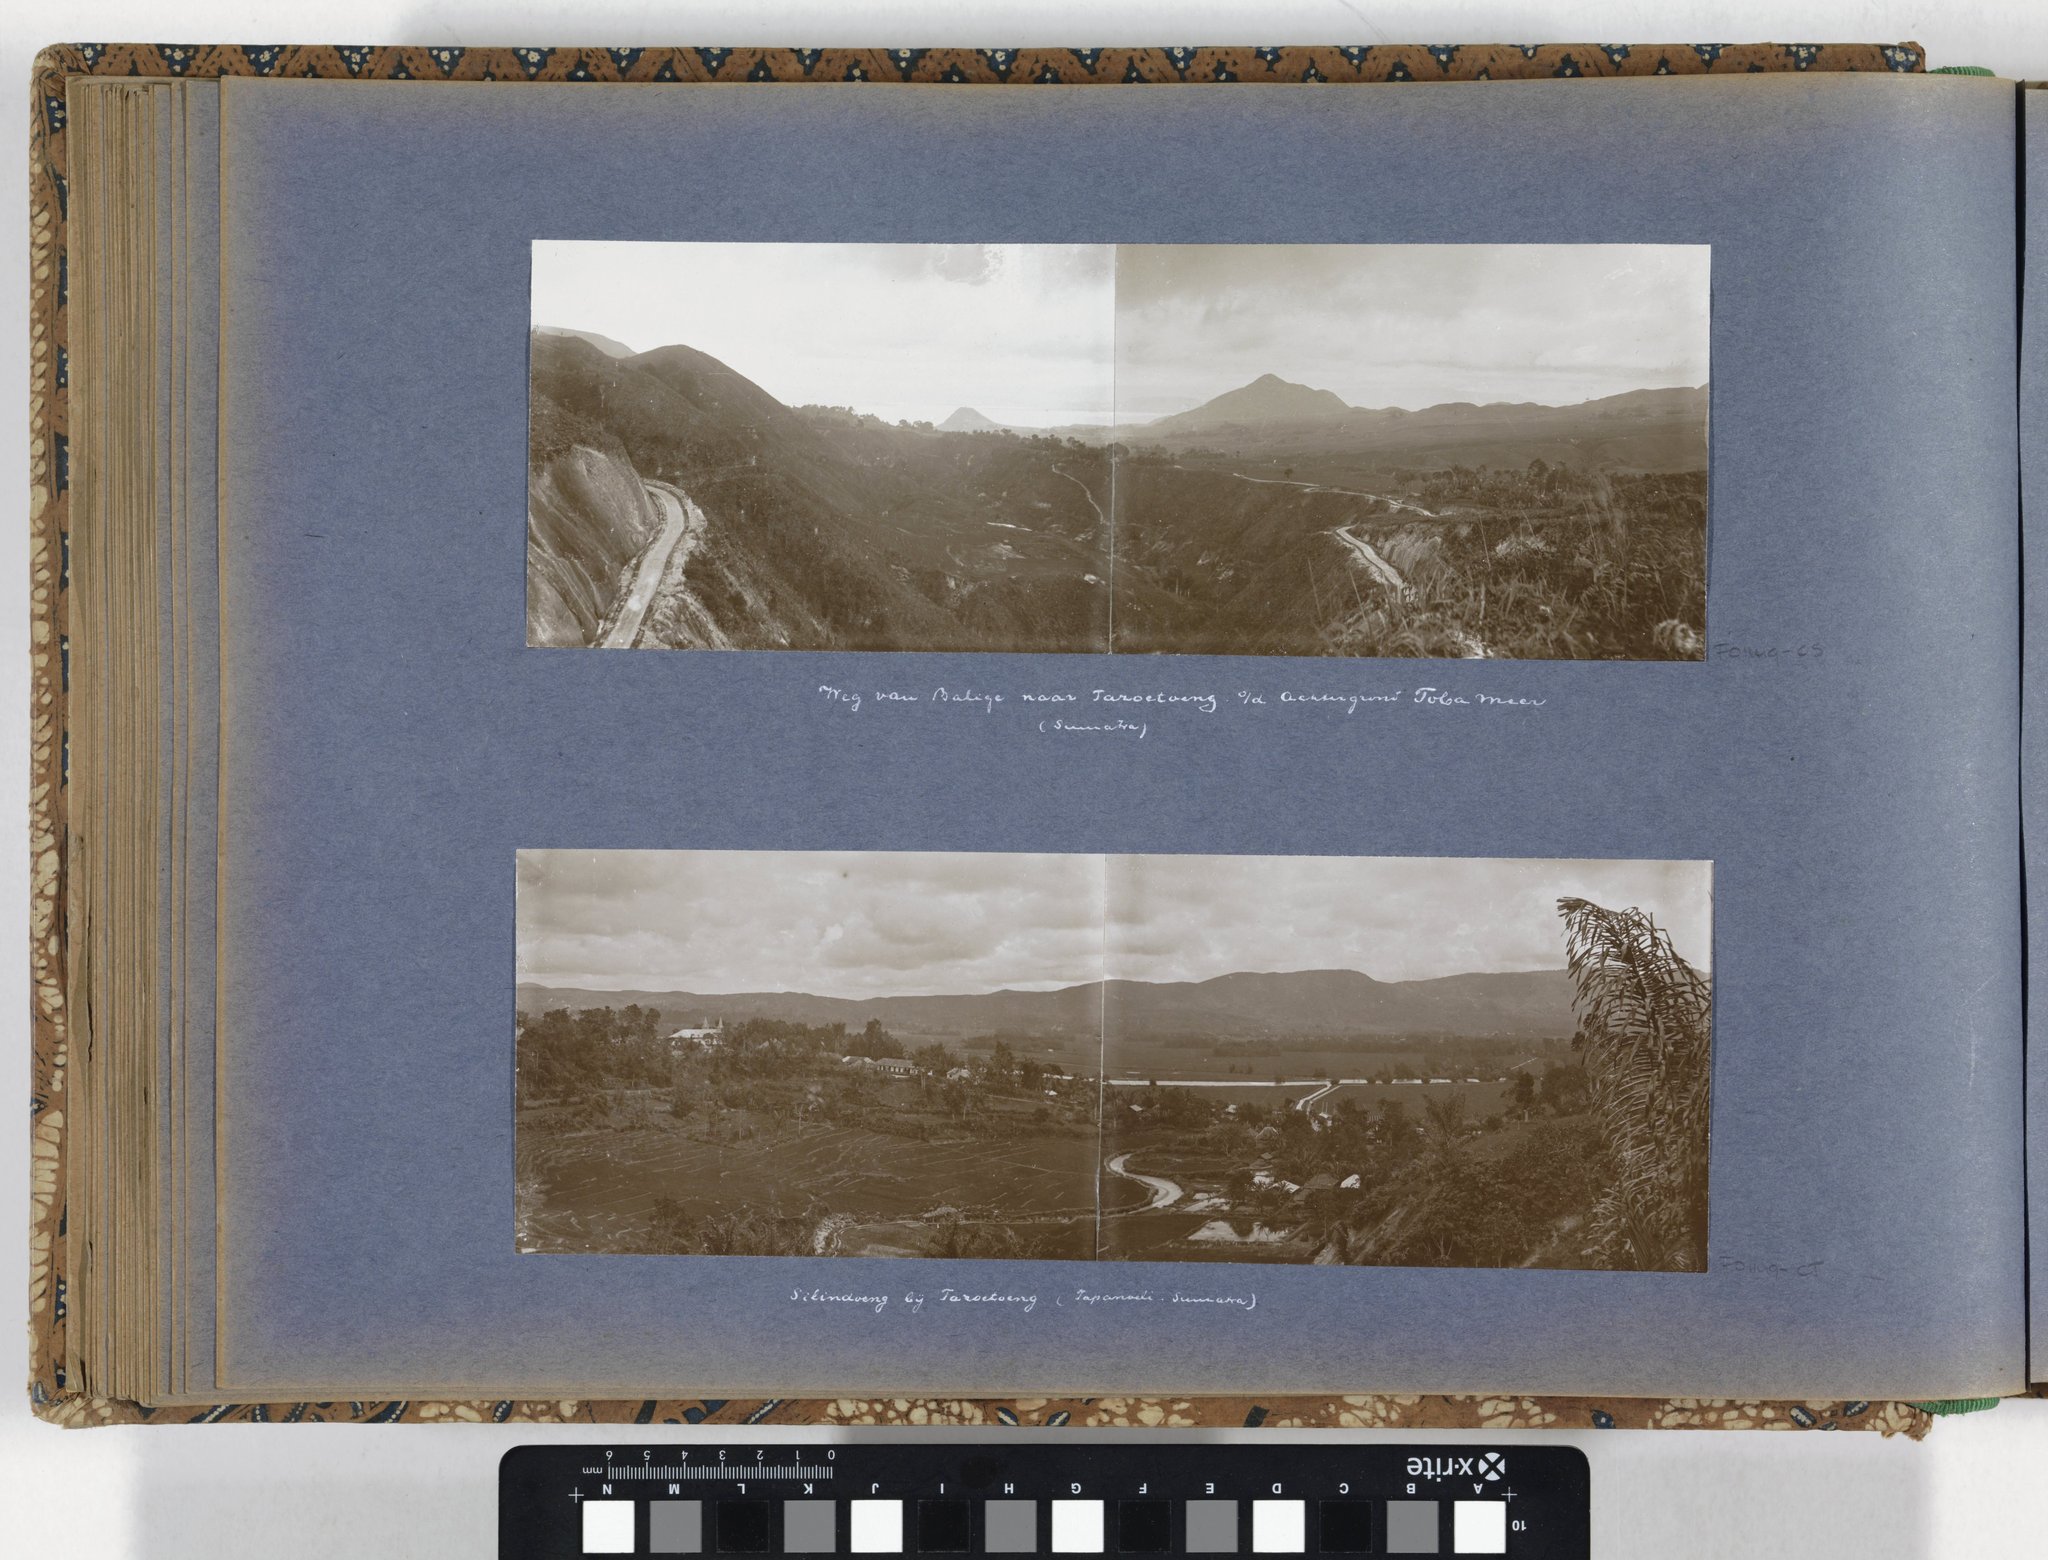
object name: photograph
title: Gezicht op Silindoeng bij Taroetoeng op Sumatra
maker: Anonymous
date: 1900-1920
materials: paper, photographic support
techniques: gelatin silver print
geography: sumatra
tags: prospect of village, silhouette of village, sumatra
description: Panoramafoto bestaande uit twee afdrukken.